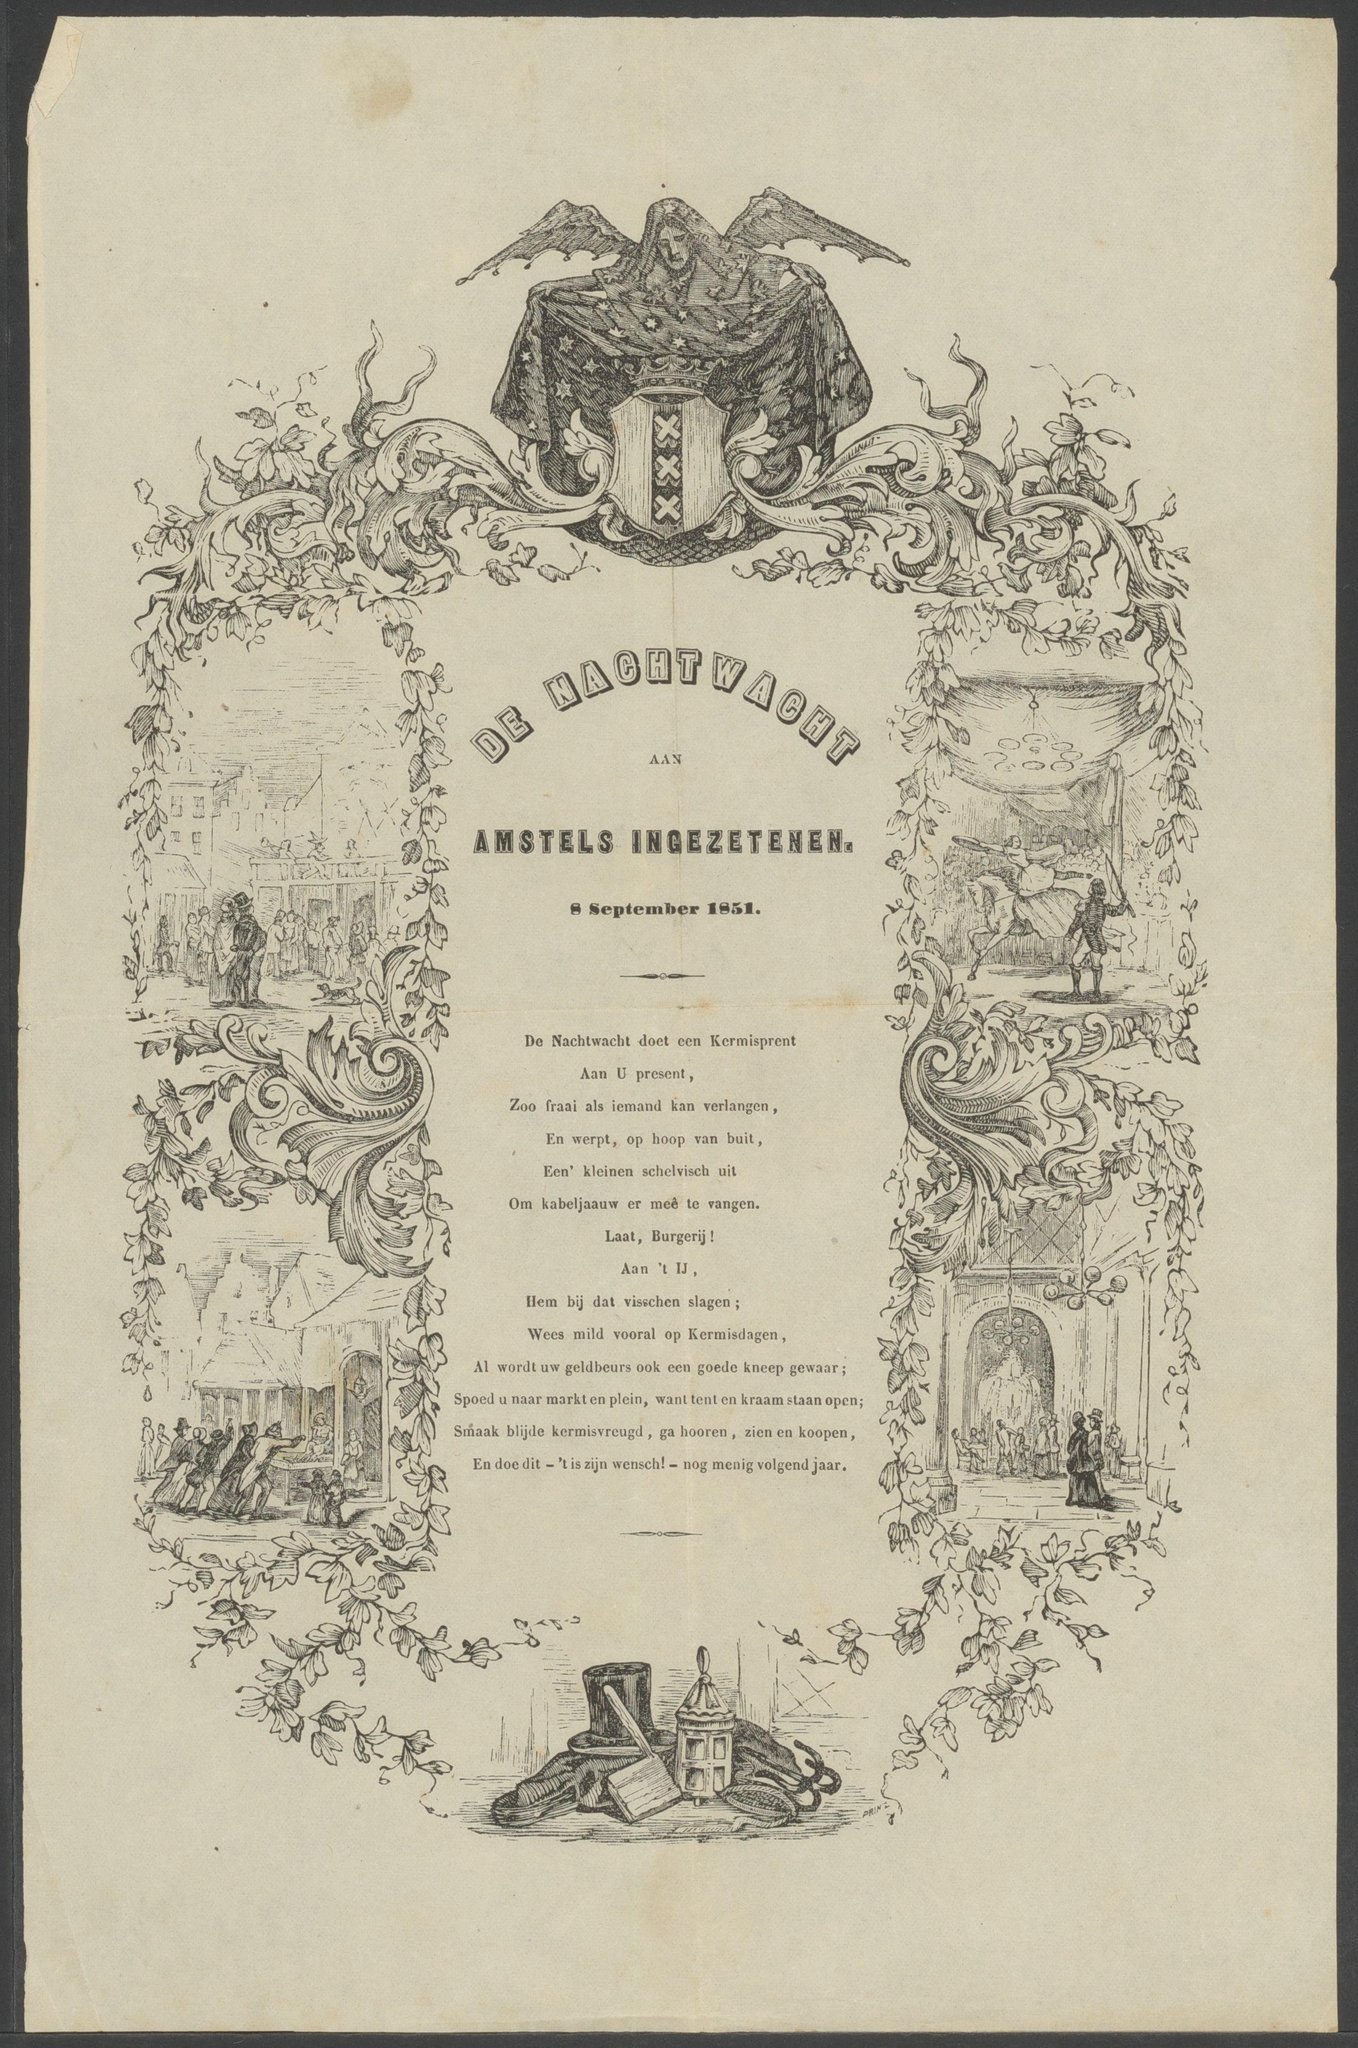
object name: print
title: Kermisprent van de Amsterdamse nachtwacht voor het jaar 1851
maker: Anonymous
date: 1851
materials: paper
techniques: letterpress printing, engraving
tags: night patrol, armorial bearing, heraldry, amsterdam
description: Kermisprent van de Amsterdamse nachtwacht, 8 september 1851. Centraal een gedicht met bovenaan het wapen van Amsterdam en een gevleugelde vrouw. Aan de zijkanten verschillende gezichten op de kermis. Onderwerpsrubrieken binnen de Atlas Zeden en Gewoonten: Zeden en gewoonten in engeren zin, Volksleven, Volksbladen, Nieuwjaars- en Kerstwenschen, Amsterdam.